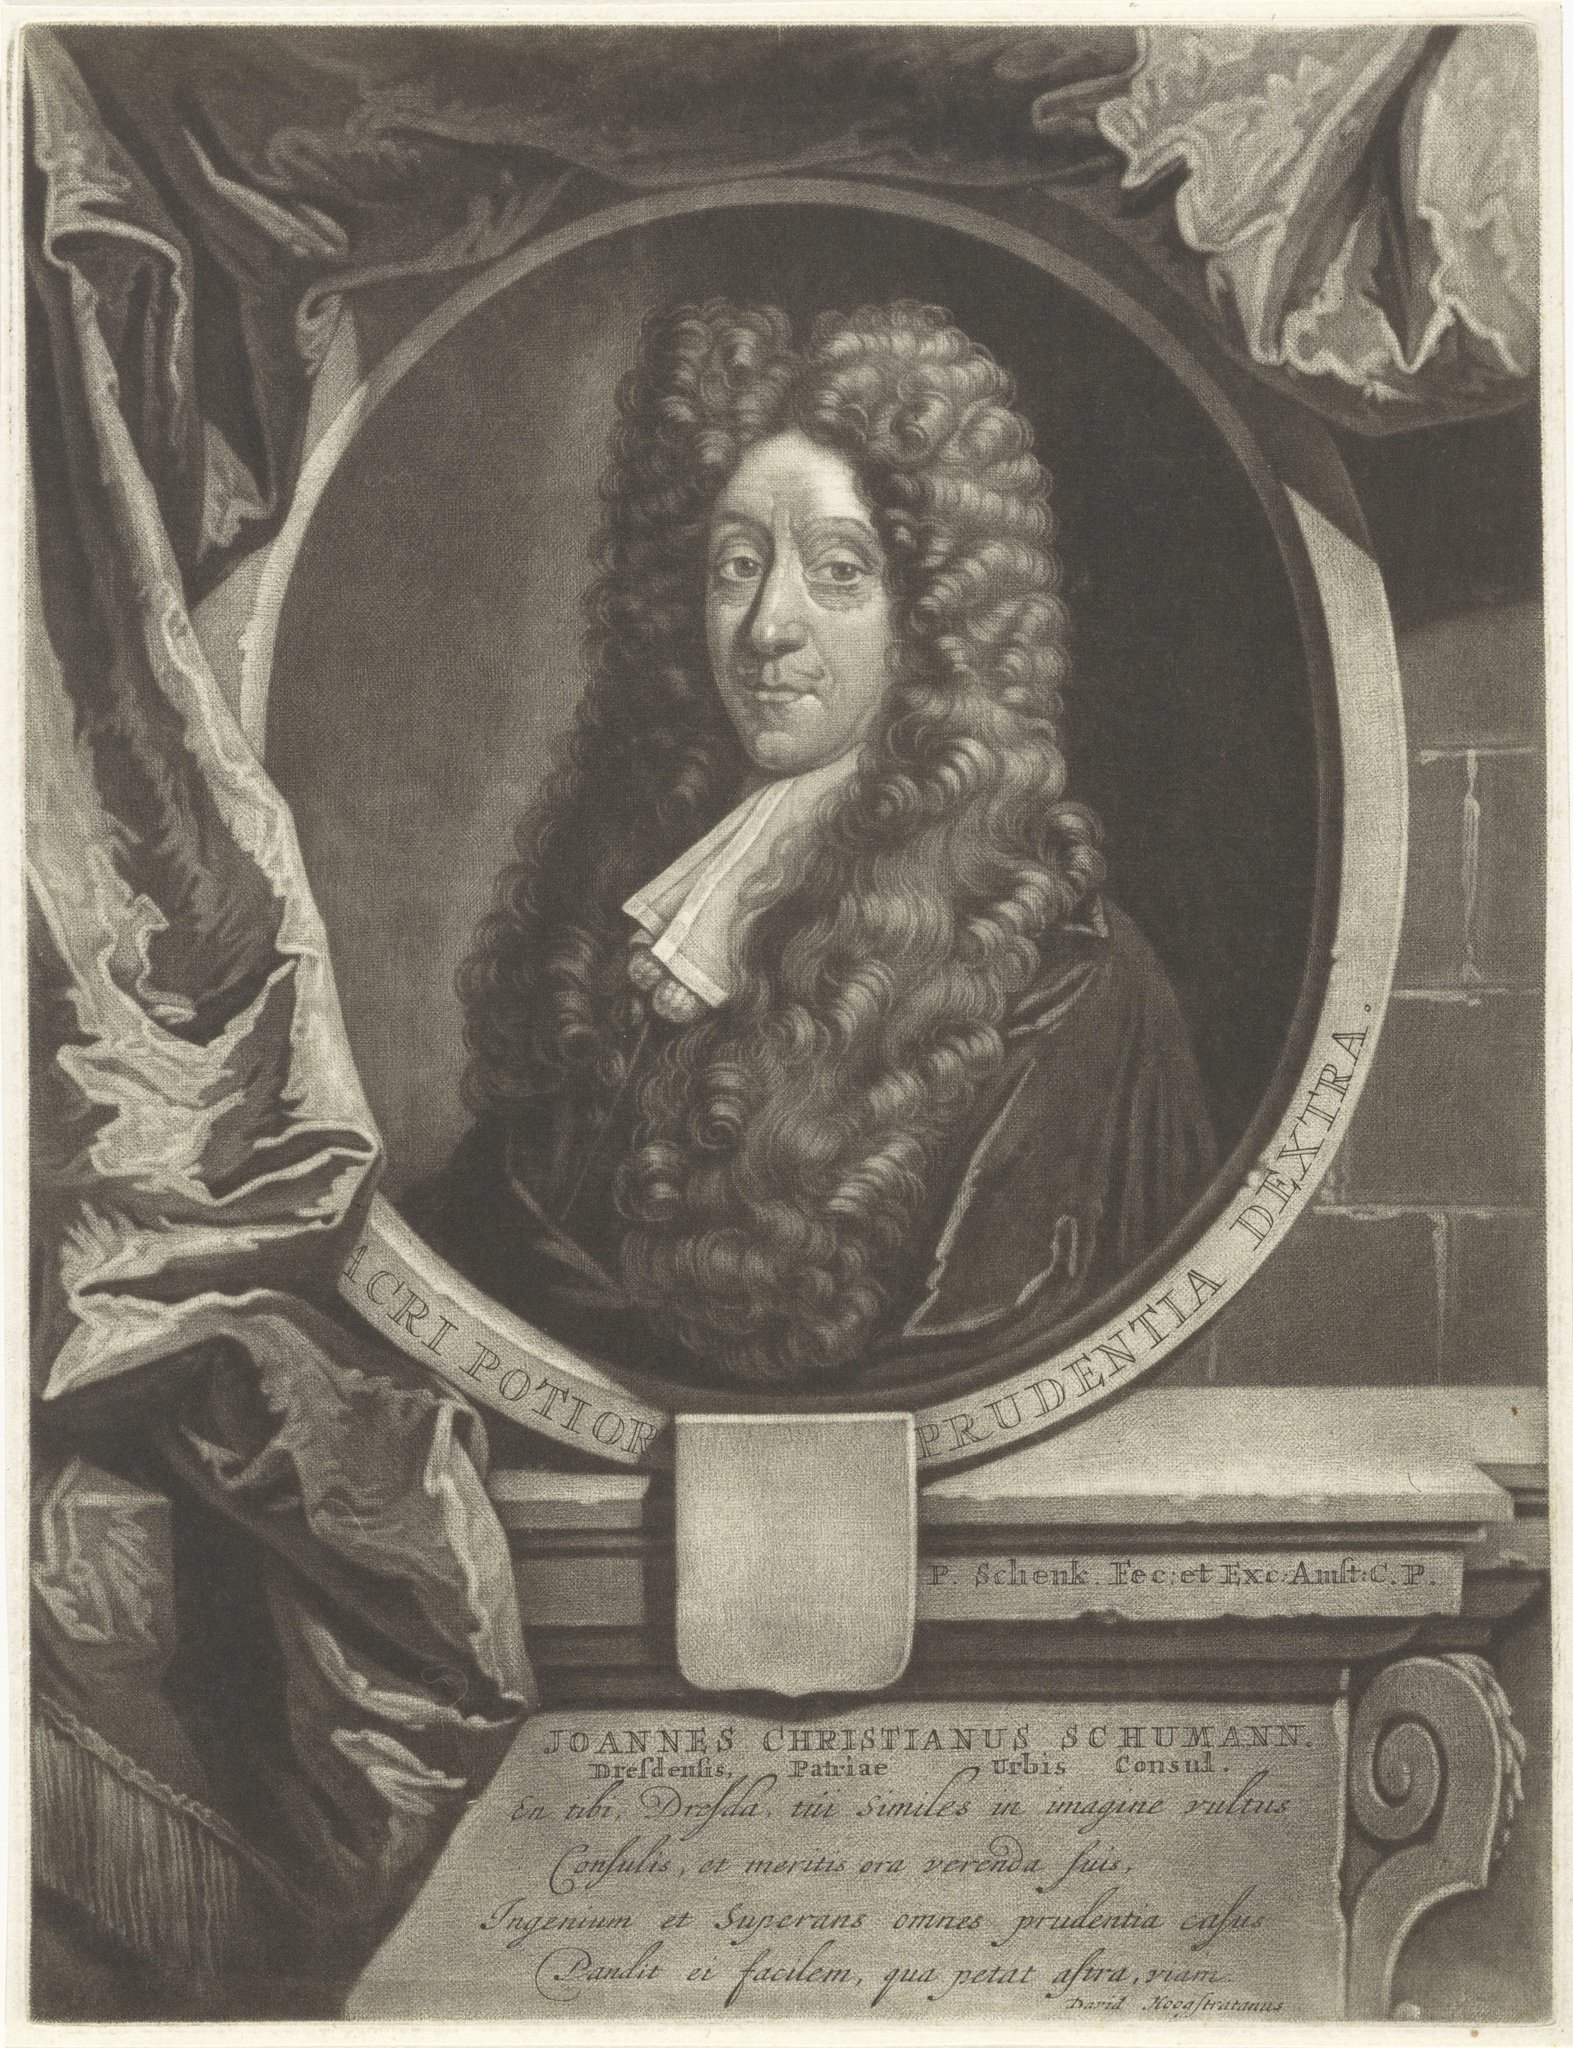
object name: print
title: Portret van Johann Christian Schumann, burgemeester van Dresden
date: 1670-1713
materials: paper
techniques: engraving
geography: amsterdam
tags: mayor, johann christian schumann, wig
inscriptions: collector's mark: Lugt 2228